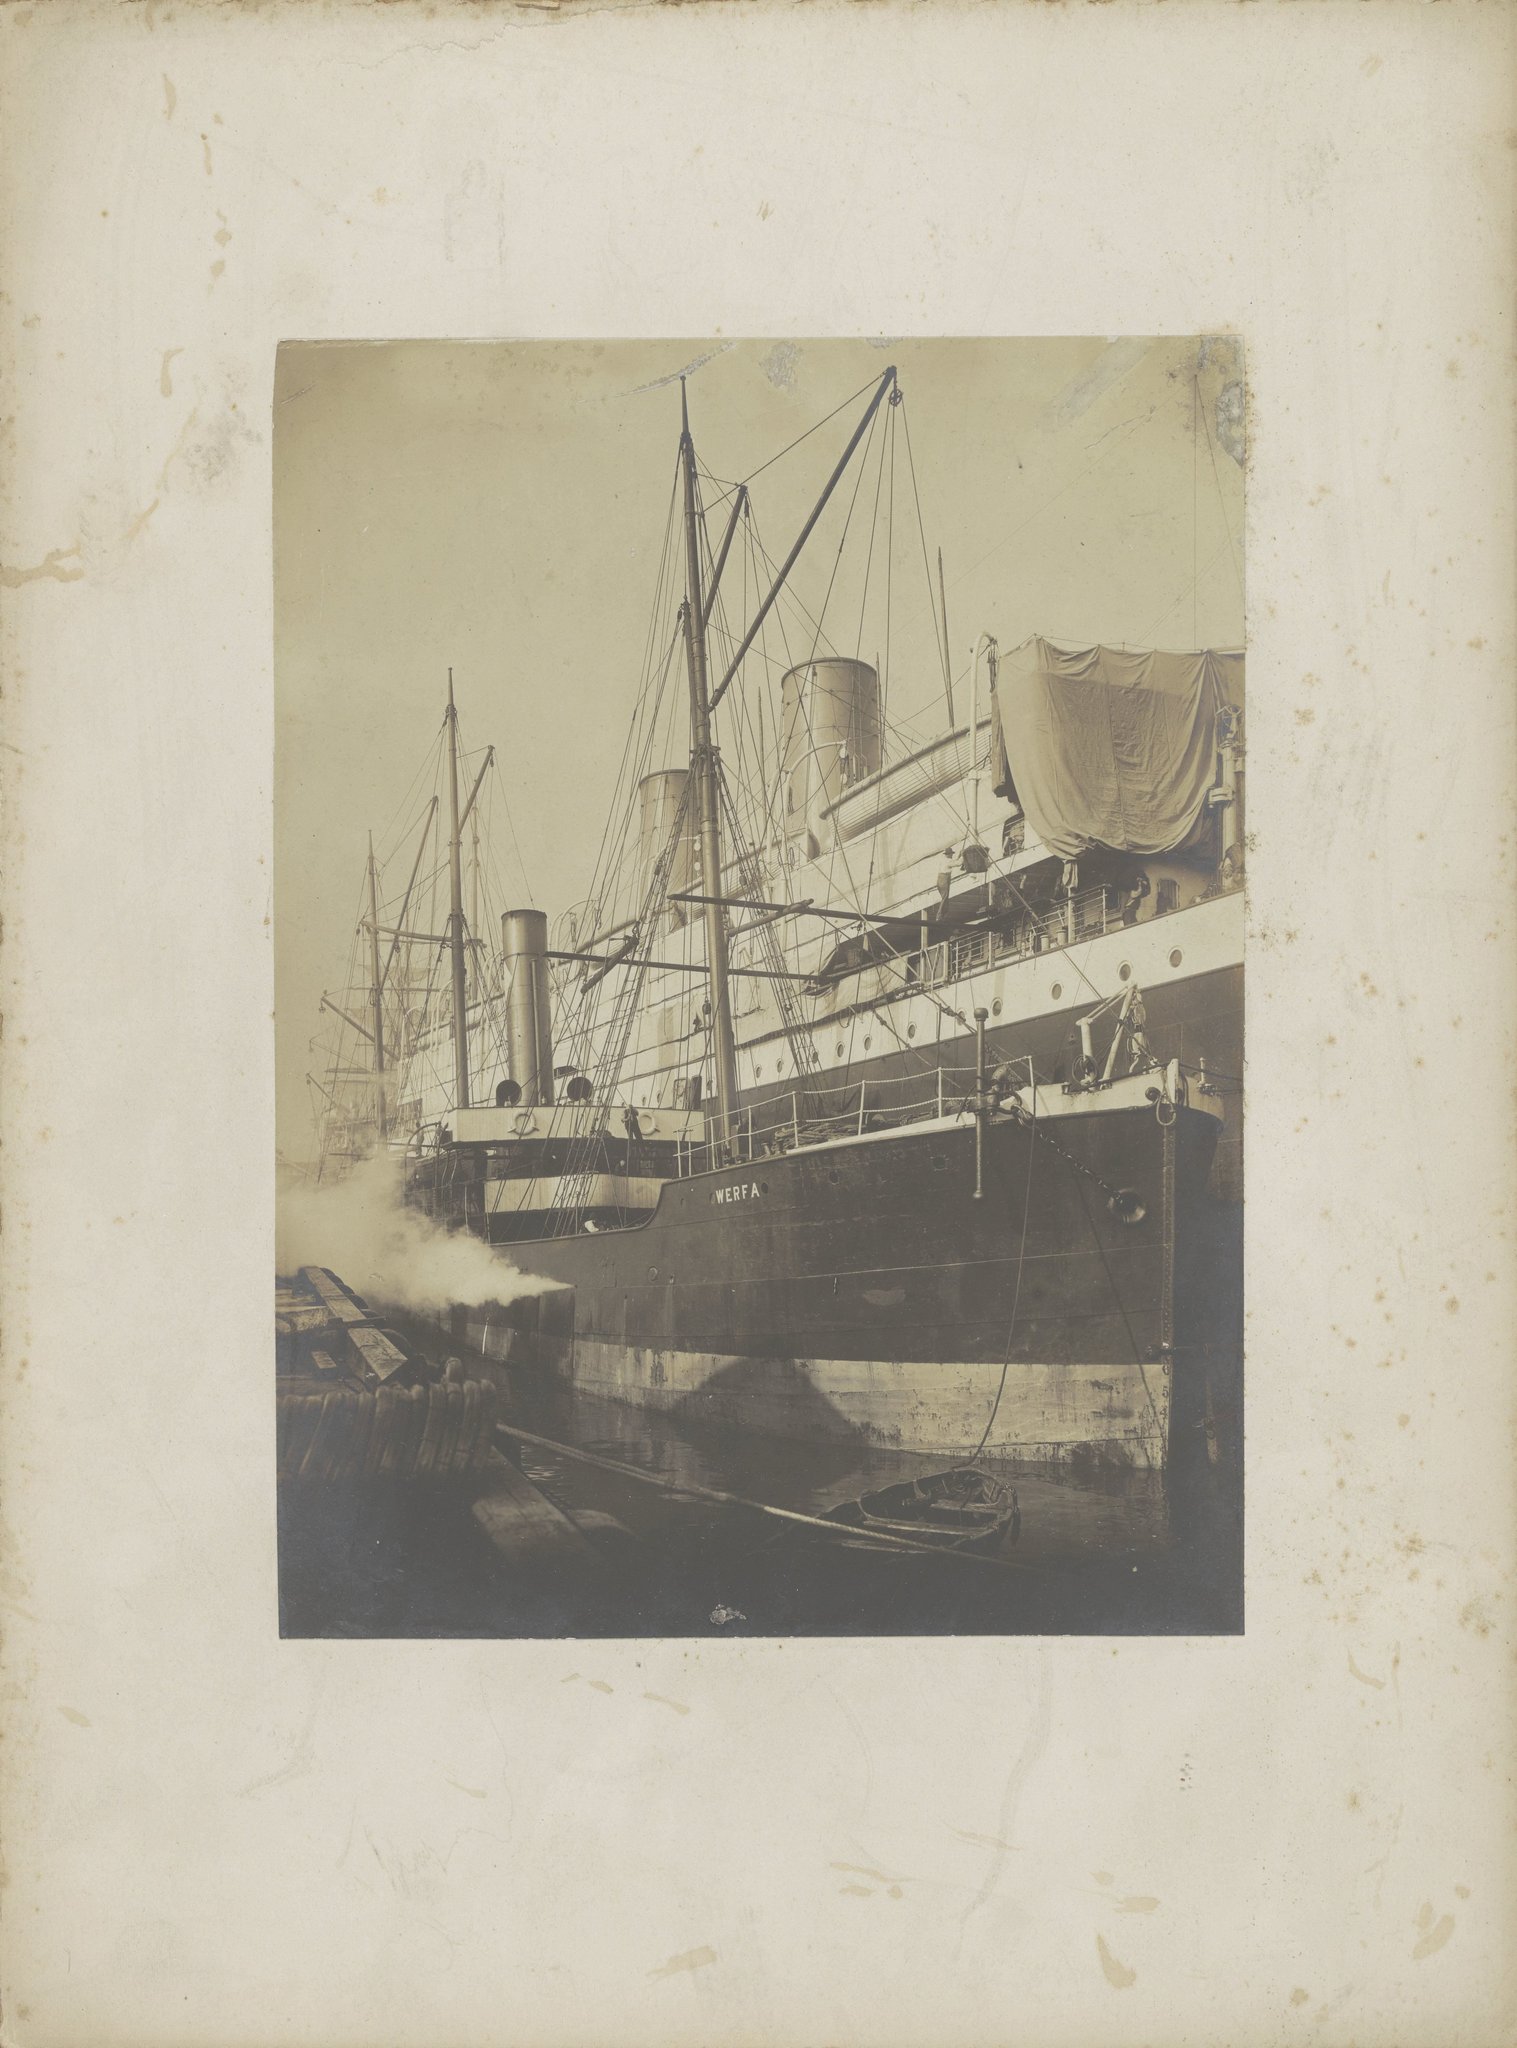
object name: photograph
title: Kolenschip 'Werfa' naast een oceaanstomer, vermoedelijk in de haven van Sydney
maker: Anonymous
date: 1890-1910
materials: cardboard, paper, photographic support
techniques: gelatin silver print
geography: sydney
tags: freight vessel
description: Onderdeel van Reisalbum met foto's van bezienswaardigheden in Sydney.